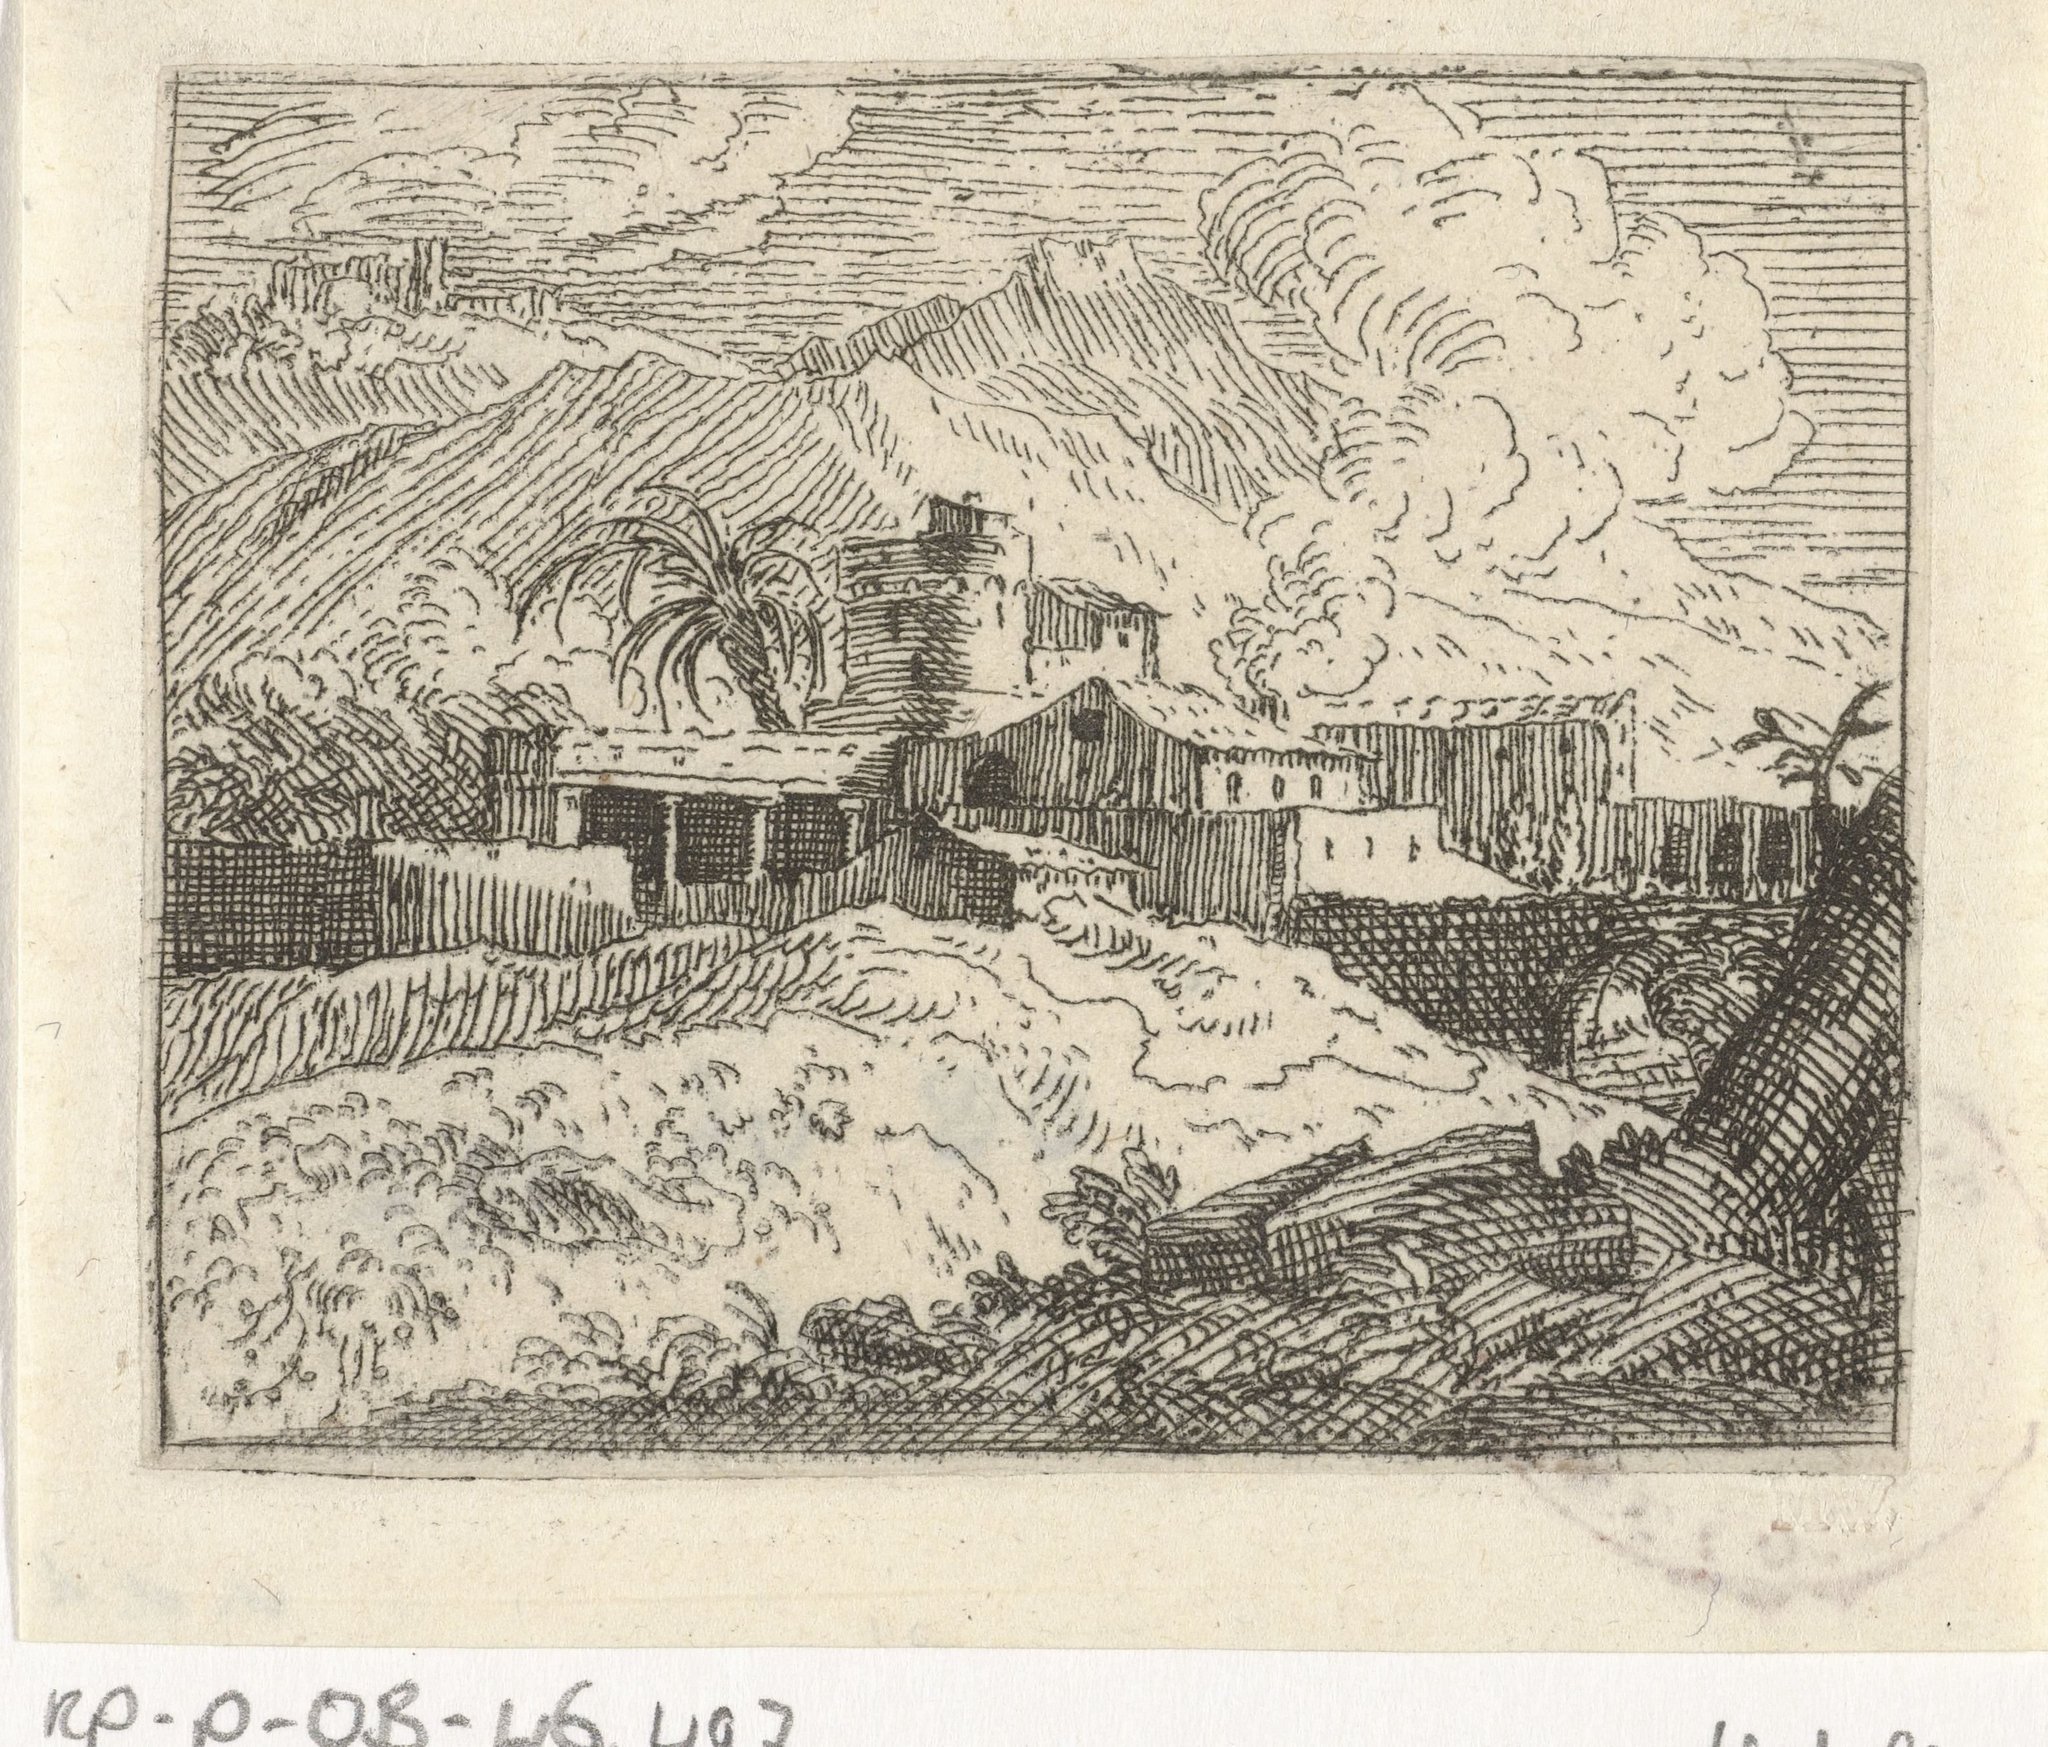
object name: print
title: Italiaanse landschappen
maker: govert van der leeuw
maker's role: print maker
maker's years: 1645-1688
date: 1655-1688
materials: paper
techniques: etching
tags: city-view, and landscape with man-made constructions, (high) hill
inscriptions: collector's mark: Lugt 240, collector's mark: Lugt 1920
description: Gezicht op een groep gebouwen, waaronder een antiek bouwsel met drie zuilen, in een berglandschap. De prent maakt deel uit van een negendelige serie prenten met voorstellingen van Italiaanse landschappen.